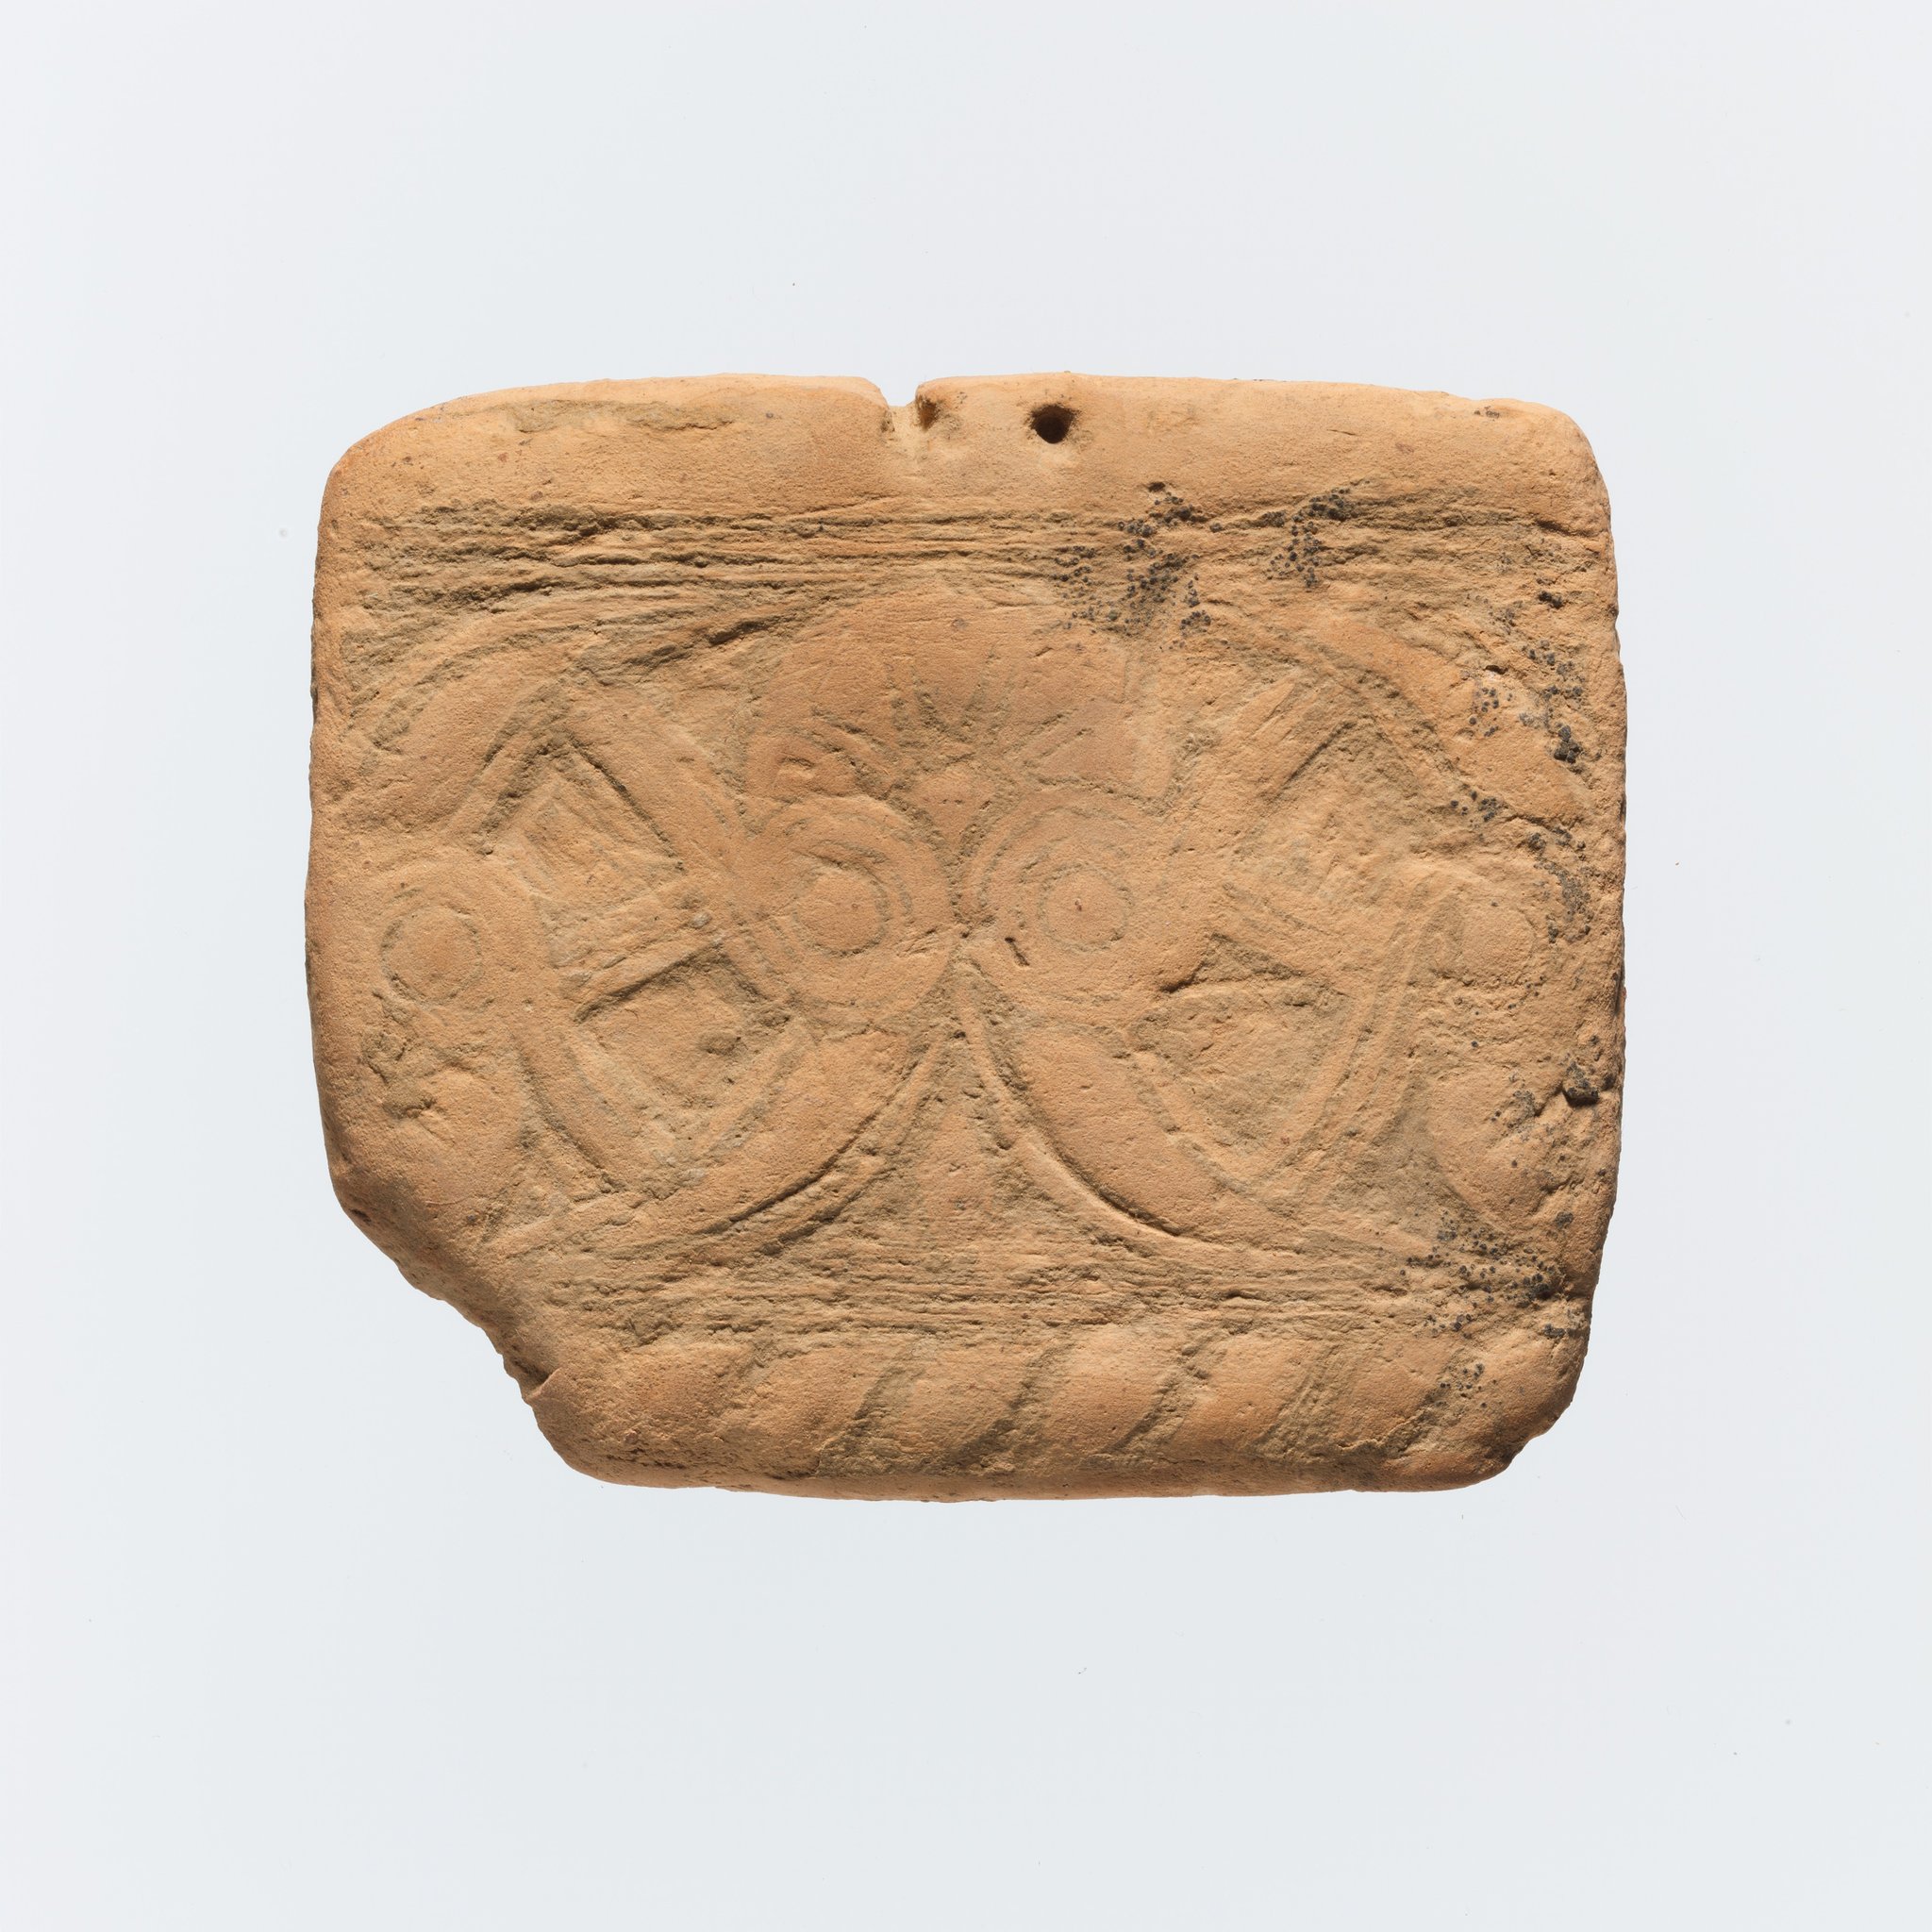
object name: pinax, palm leaf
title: Terracotta plaque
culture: greek, cretan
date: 600-501 BCE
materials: terracotta